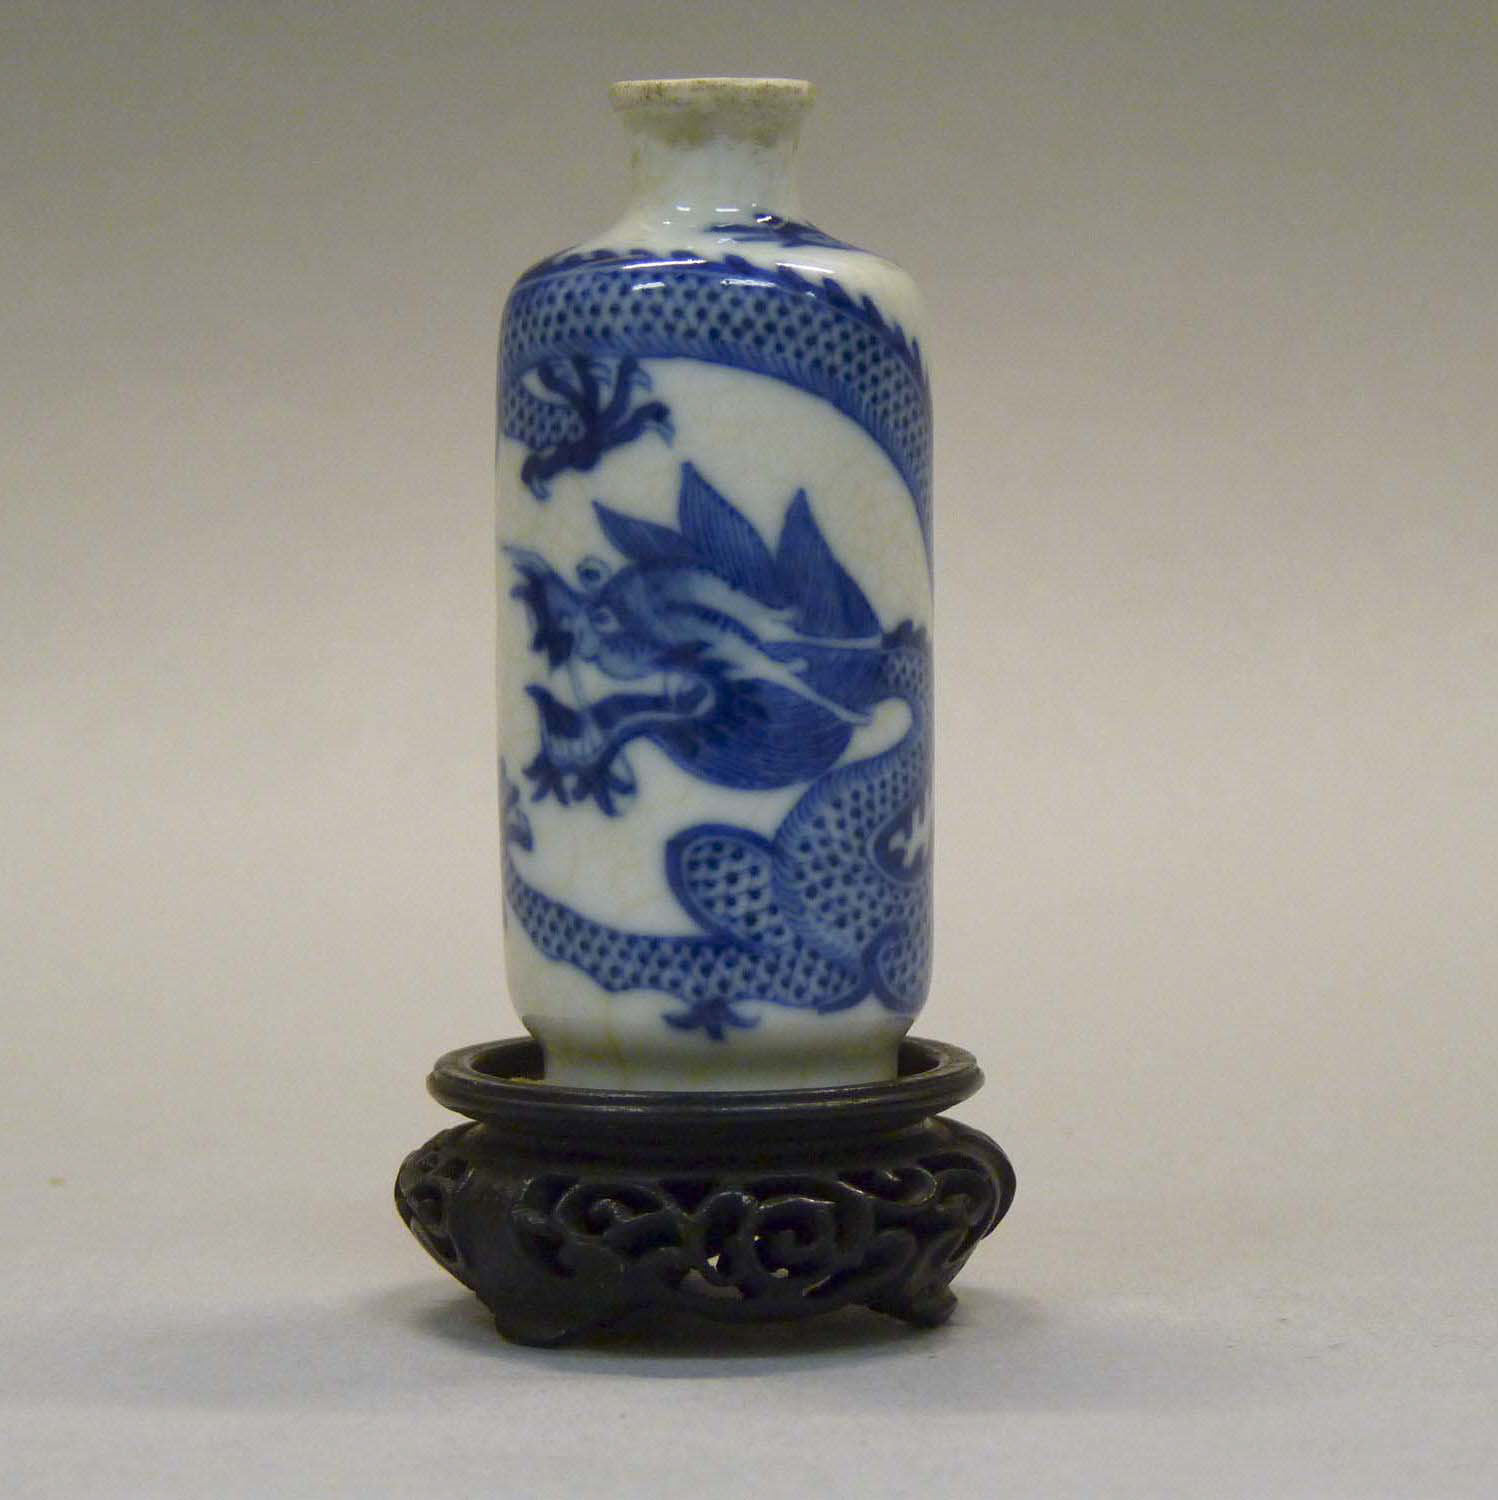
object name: snuff bottle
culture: chinese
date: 1736-1795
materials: paste, porcelain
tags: dragons